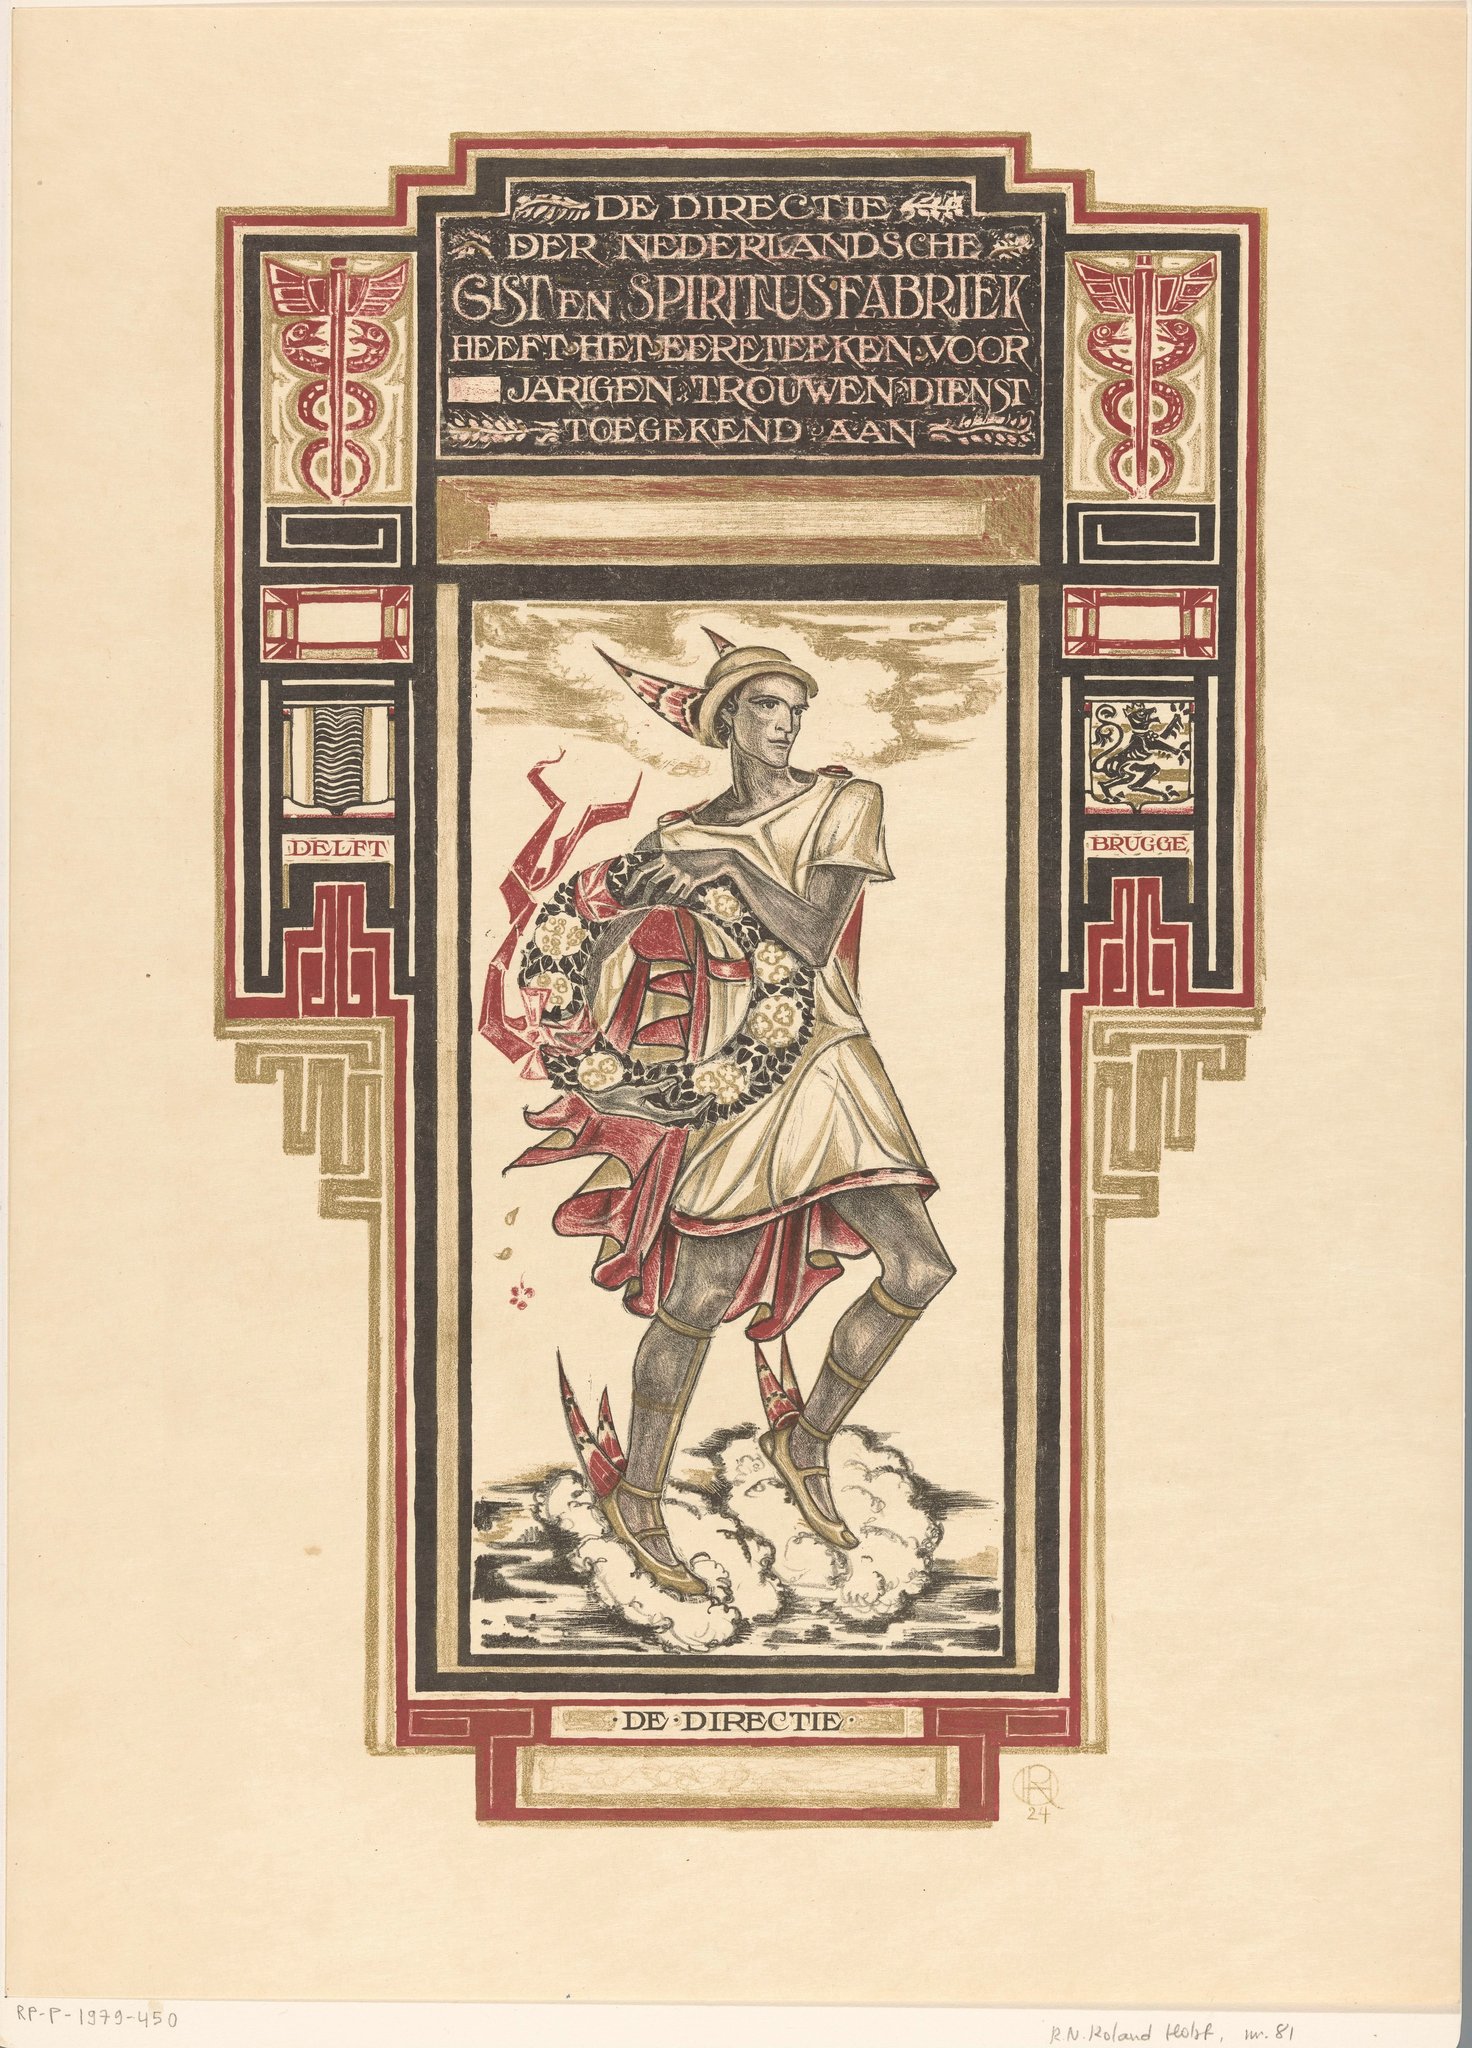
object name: print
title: Ontwerp voor: Diploma voor trouwe dienst bij de Nederlandsche Gist- en Spiritusfabriek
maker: richard nicolaüs roland holst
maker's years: 1868-1938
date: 1924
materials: paper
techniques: lithograph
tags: garland, wreath, (story of) mercury (hermes)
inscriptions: collector's mark: Lugt 2228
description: Hermes, herkenbaar aan zijn gevleugelde sandalen en petasus (hoed), die een bloemenkrans vasthoudt. Om het geheel een kader met links en rechts een zogenaamde caduceus, een door twee slangen omwonden staf, en de stadswapens van Delft en Brugge. Bovenaan de tekst 'De directie der Nederlandsche Gist en Spiritusfabriek heeft het eereteeken voor [...] jarigen trouwen dienst toegekend aan [...]'.